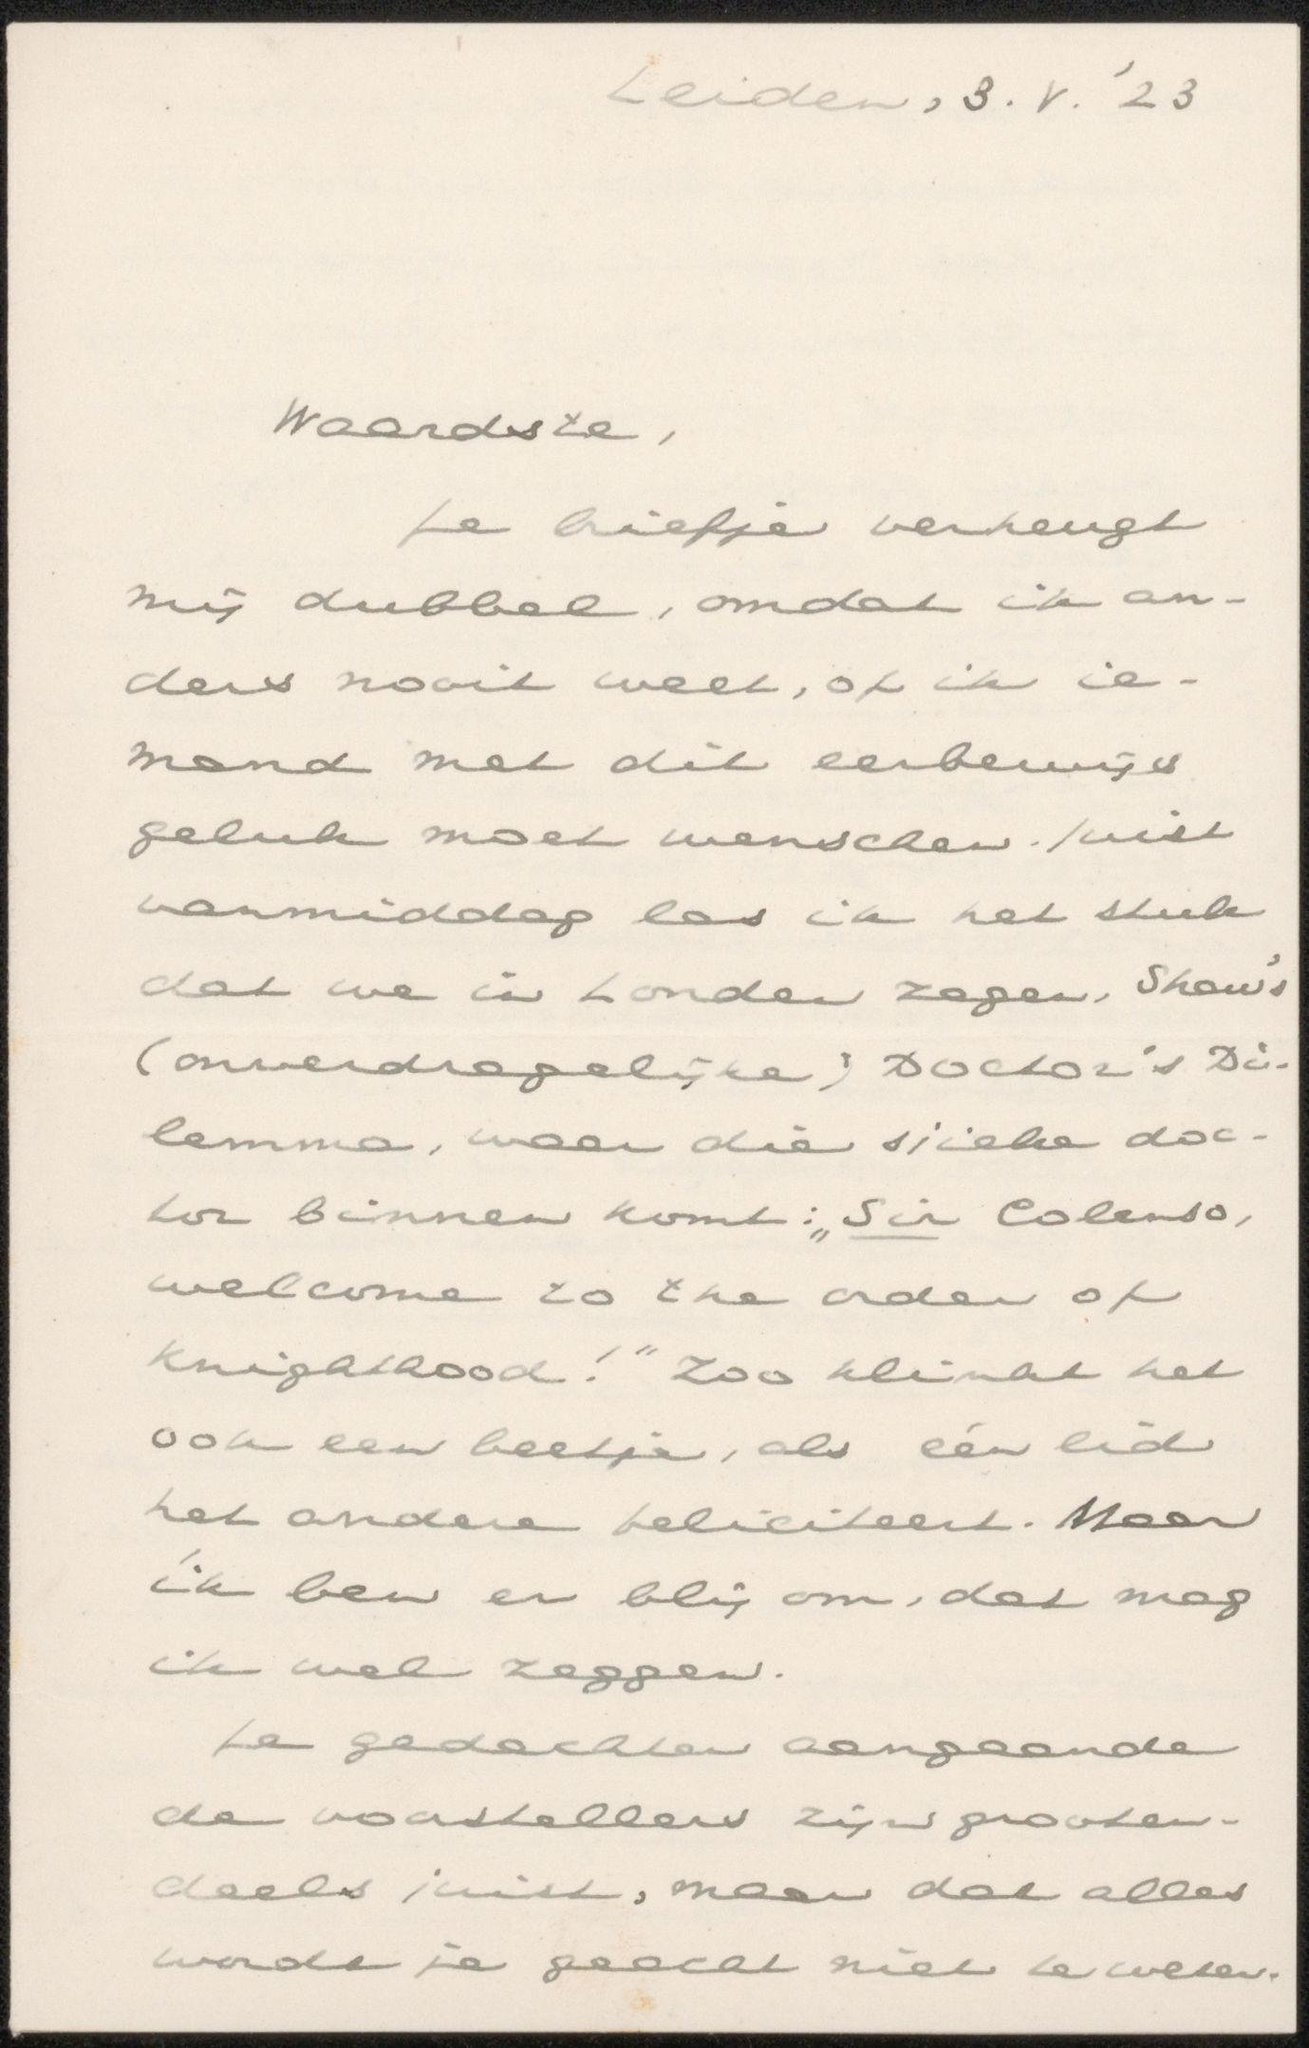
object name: letter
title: Brief aan Jan Veth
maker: johan huizinga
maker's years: 1872-1945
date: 1923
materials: ink, paper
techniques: pen, writing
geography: leiden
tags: dordrecht, painter, print maker, draughtsman, designer, jan veth, cornelis veth, den helder, utrecht, willem vogelsang, samuel muller (1848-1922), amsterdam, jonkheer jan six, abraham bredius, leiden, herman theodoor colenbrander, rotterdam, diseases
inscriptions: collector's mark: ‘RPK’, watermark